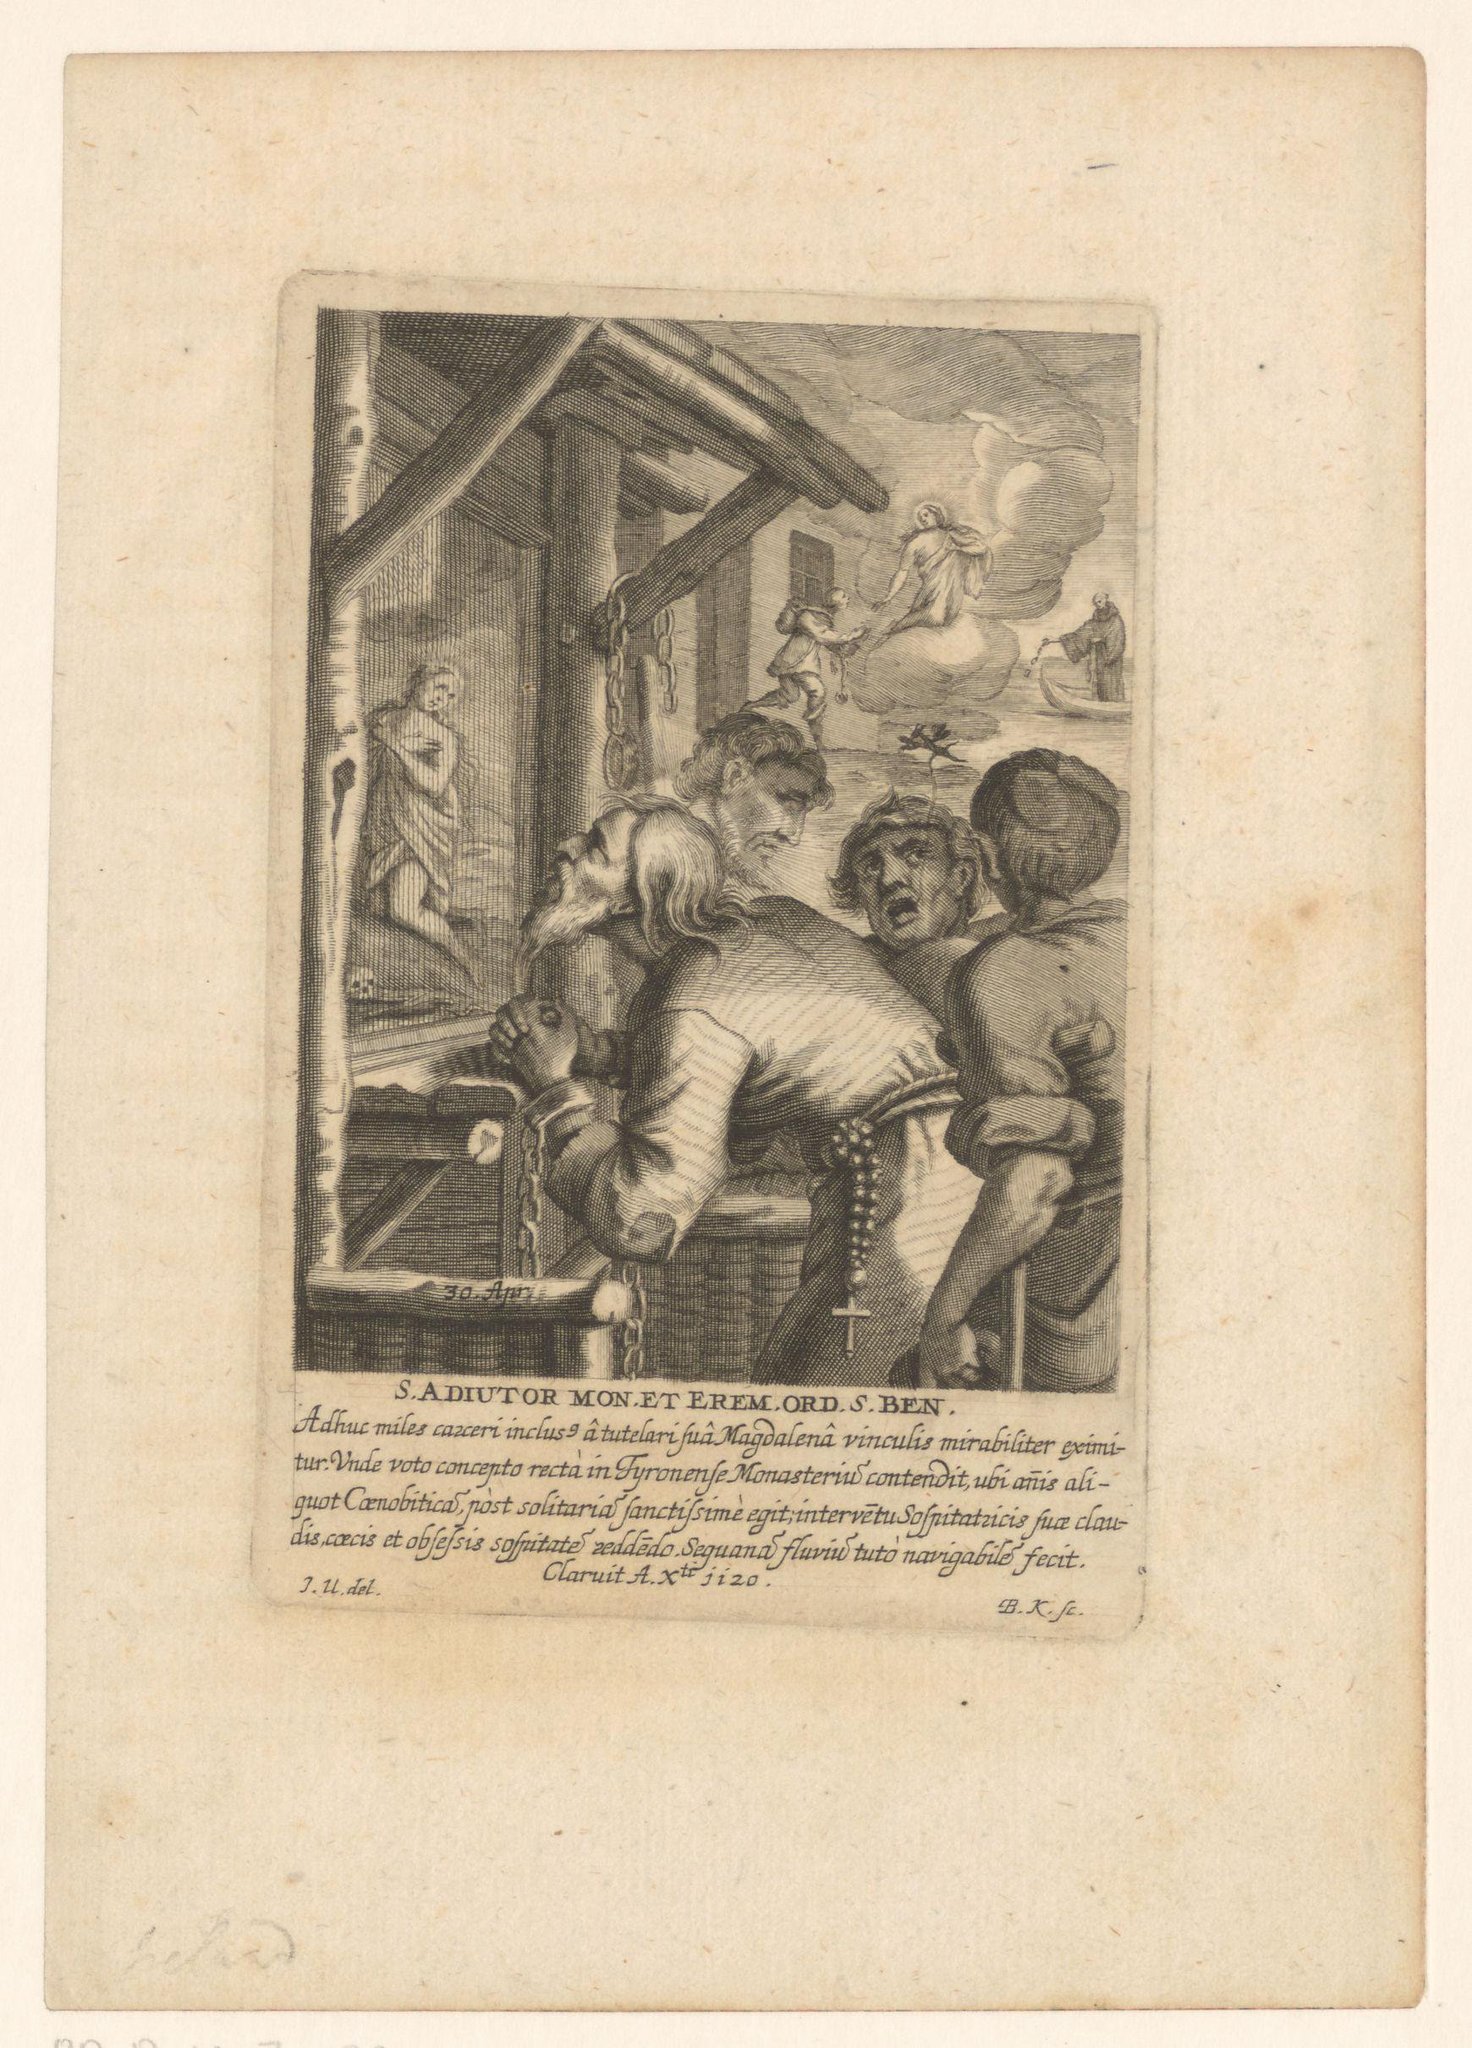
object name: print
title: H. Adjutor heeft een visioen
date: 1640-1696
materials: paper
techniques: engraving, etching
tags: saints, one person praying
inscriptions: collector's mark: Lugt 2228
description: In de marge onderaan vier regels tekst in het Latijn over deze Benedictijner monnik.